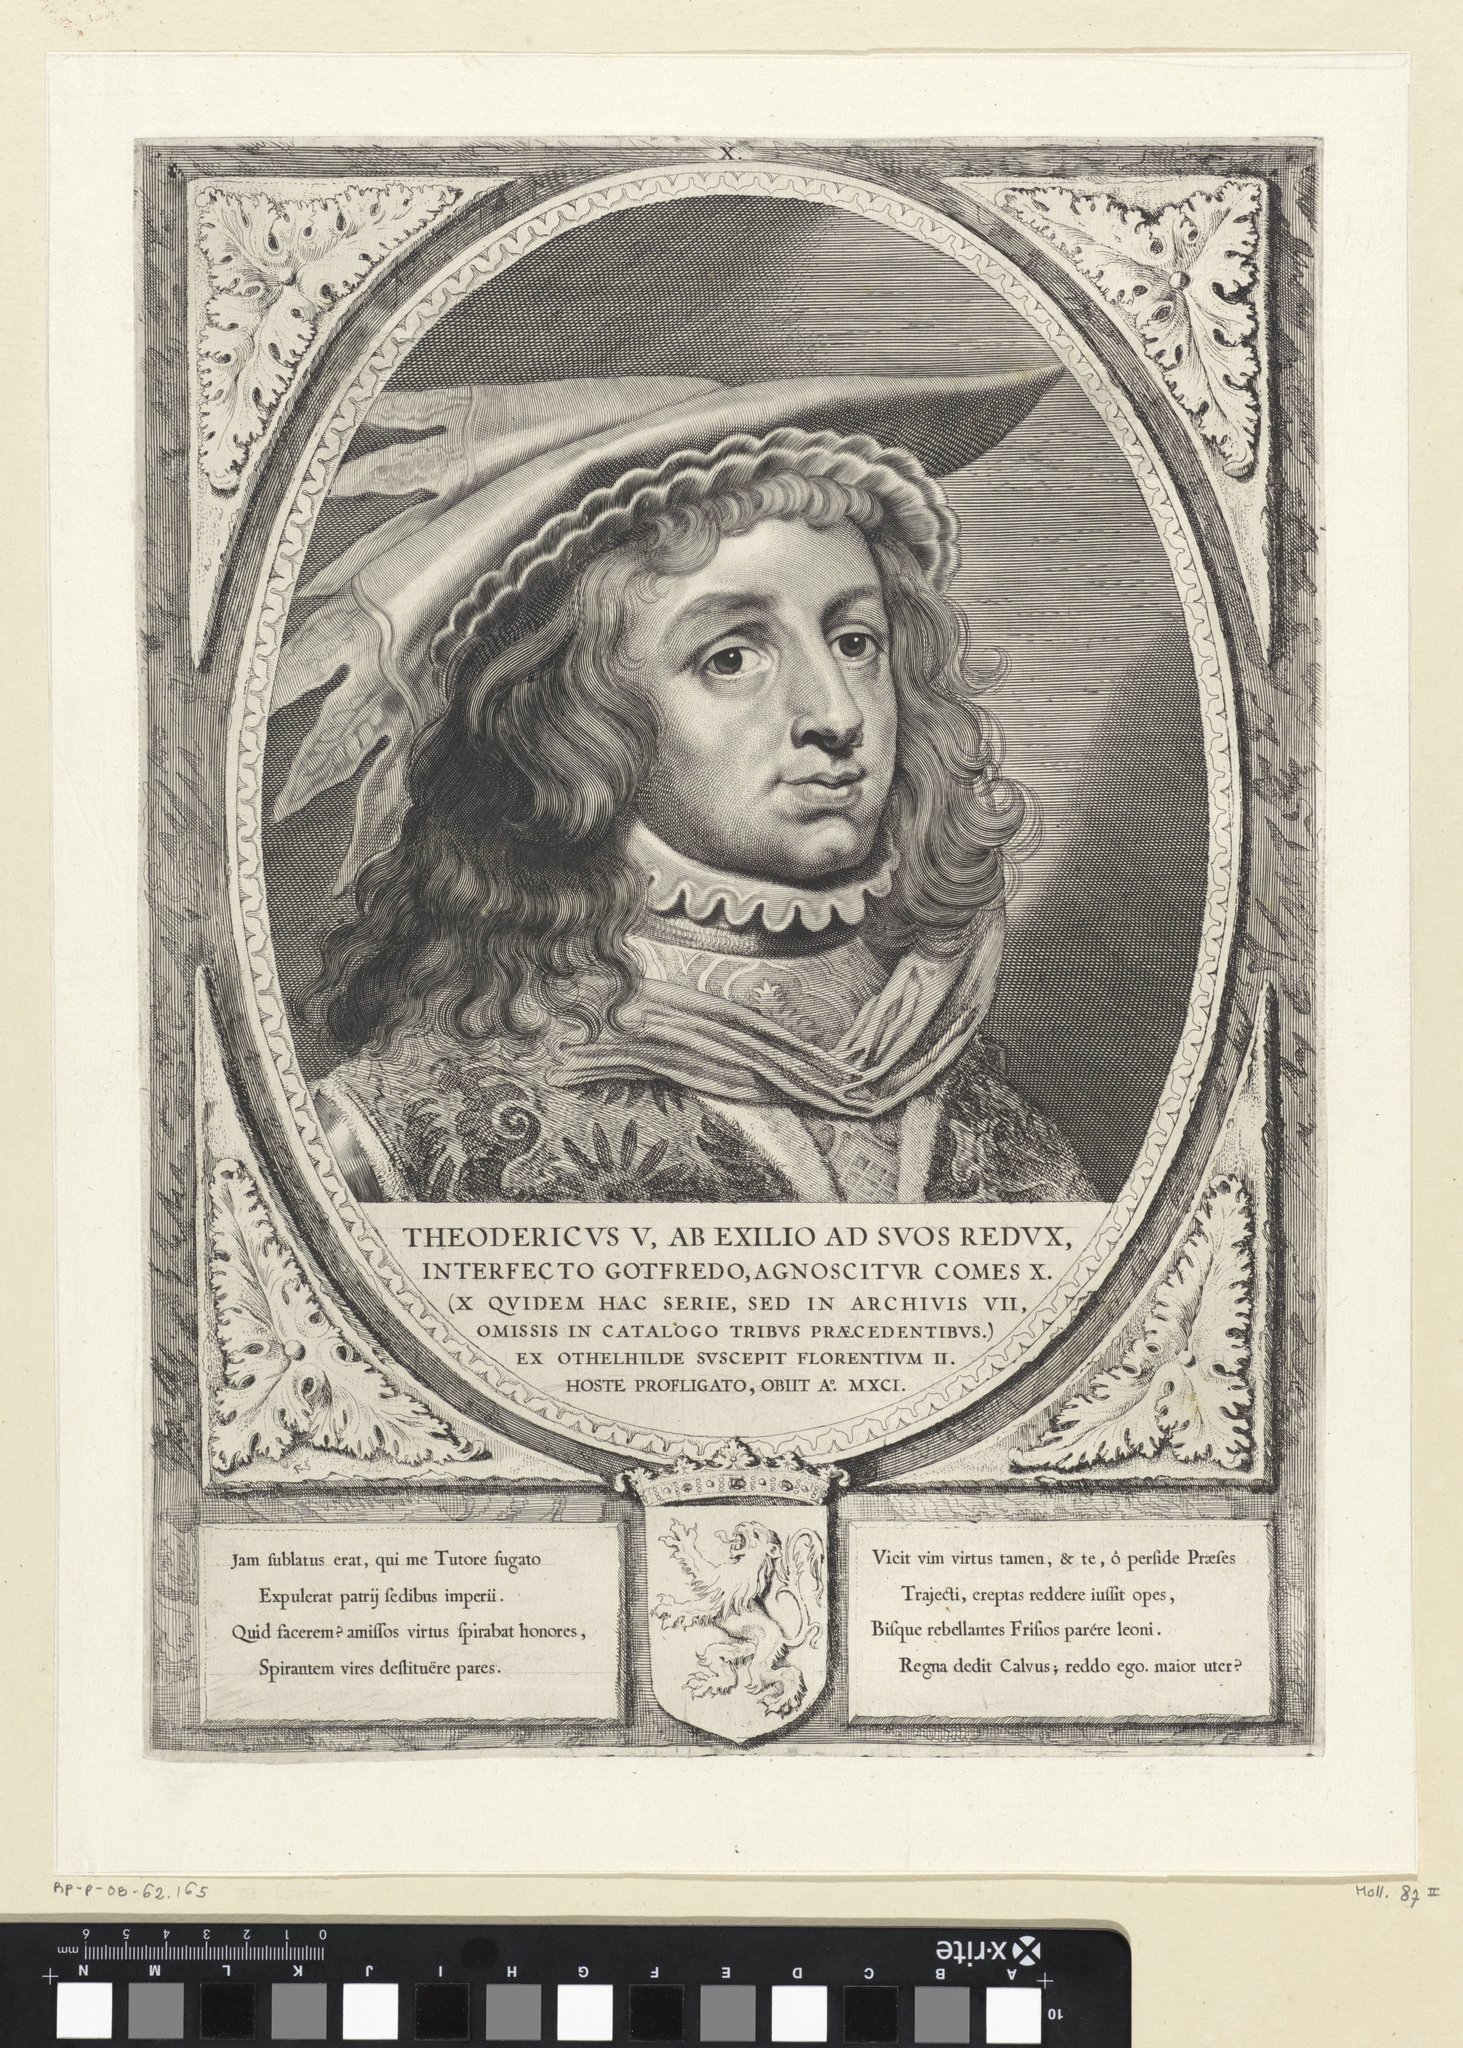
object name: print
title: Theodoricvs V, Ab Exilio Ad Svos Redvx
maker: cornelis visscher (ii)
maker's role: draughtsman, painter, print maker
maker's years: 1628-1658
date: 1650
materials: paper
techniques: engraving, etching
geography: haarlem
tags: dirk v (graaf van holland)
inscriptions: collector's mark: Lugt 12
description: Proefdruk van de tiende prent uit de serie 'Graven en gravinnen van Holland, Zeeland en West-Friesland', bestaande uit 38 prenten.